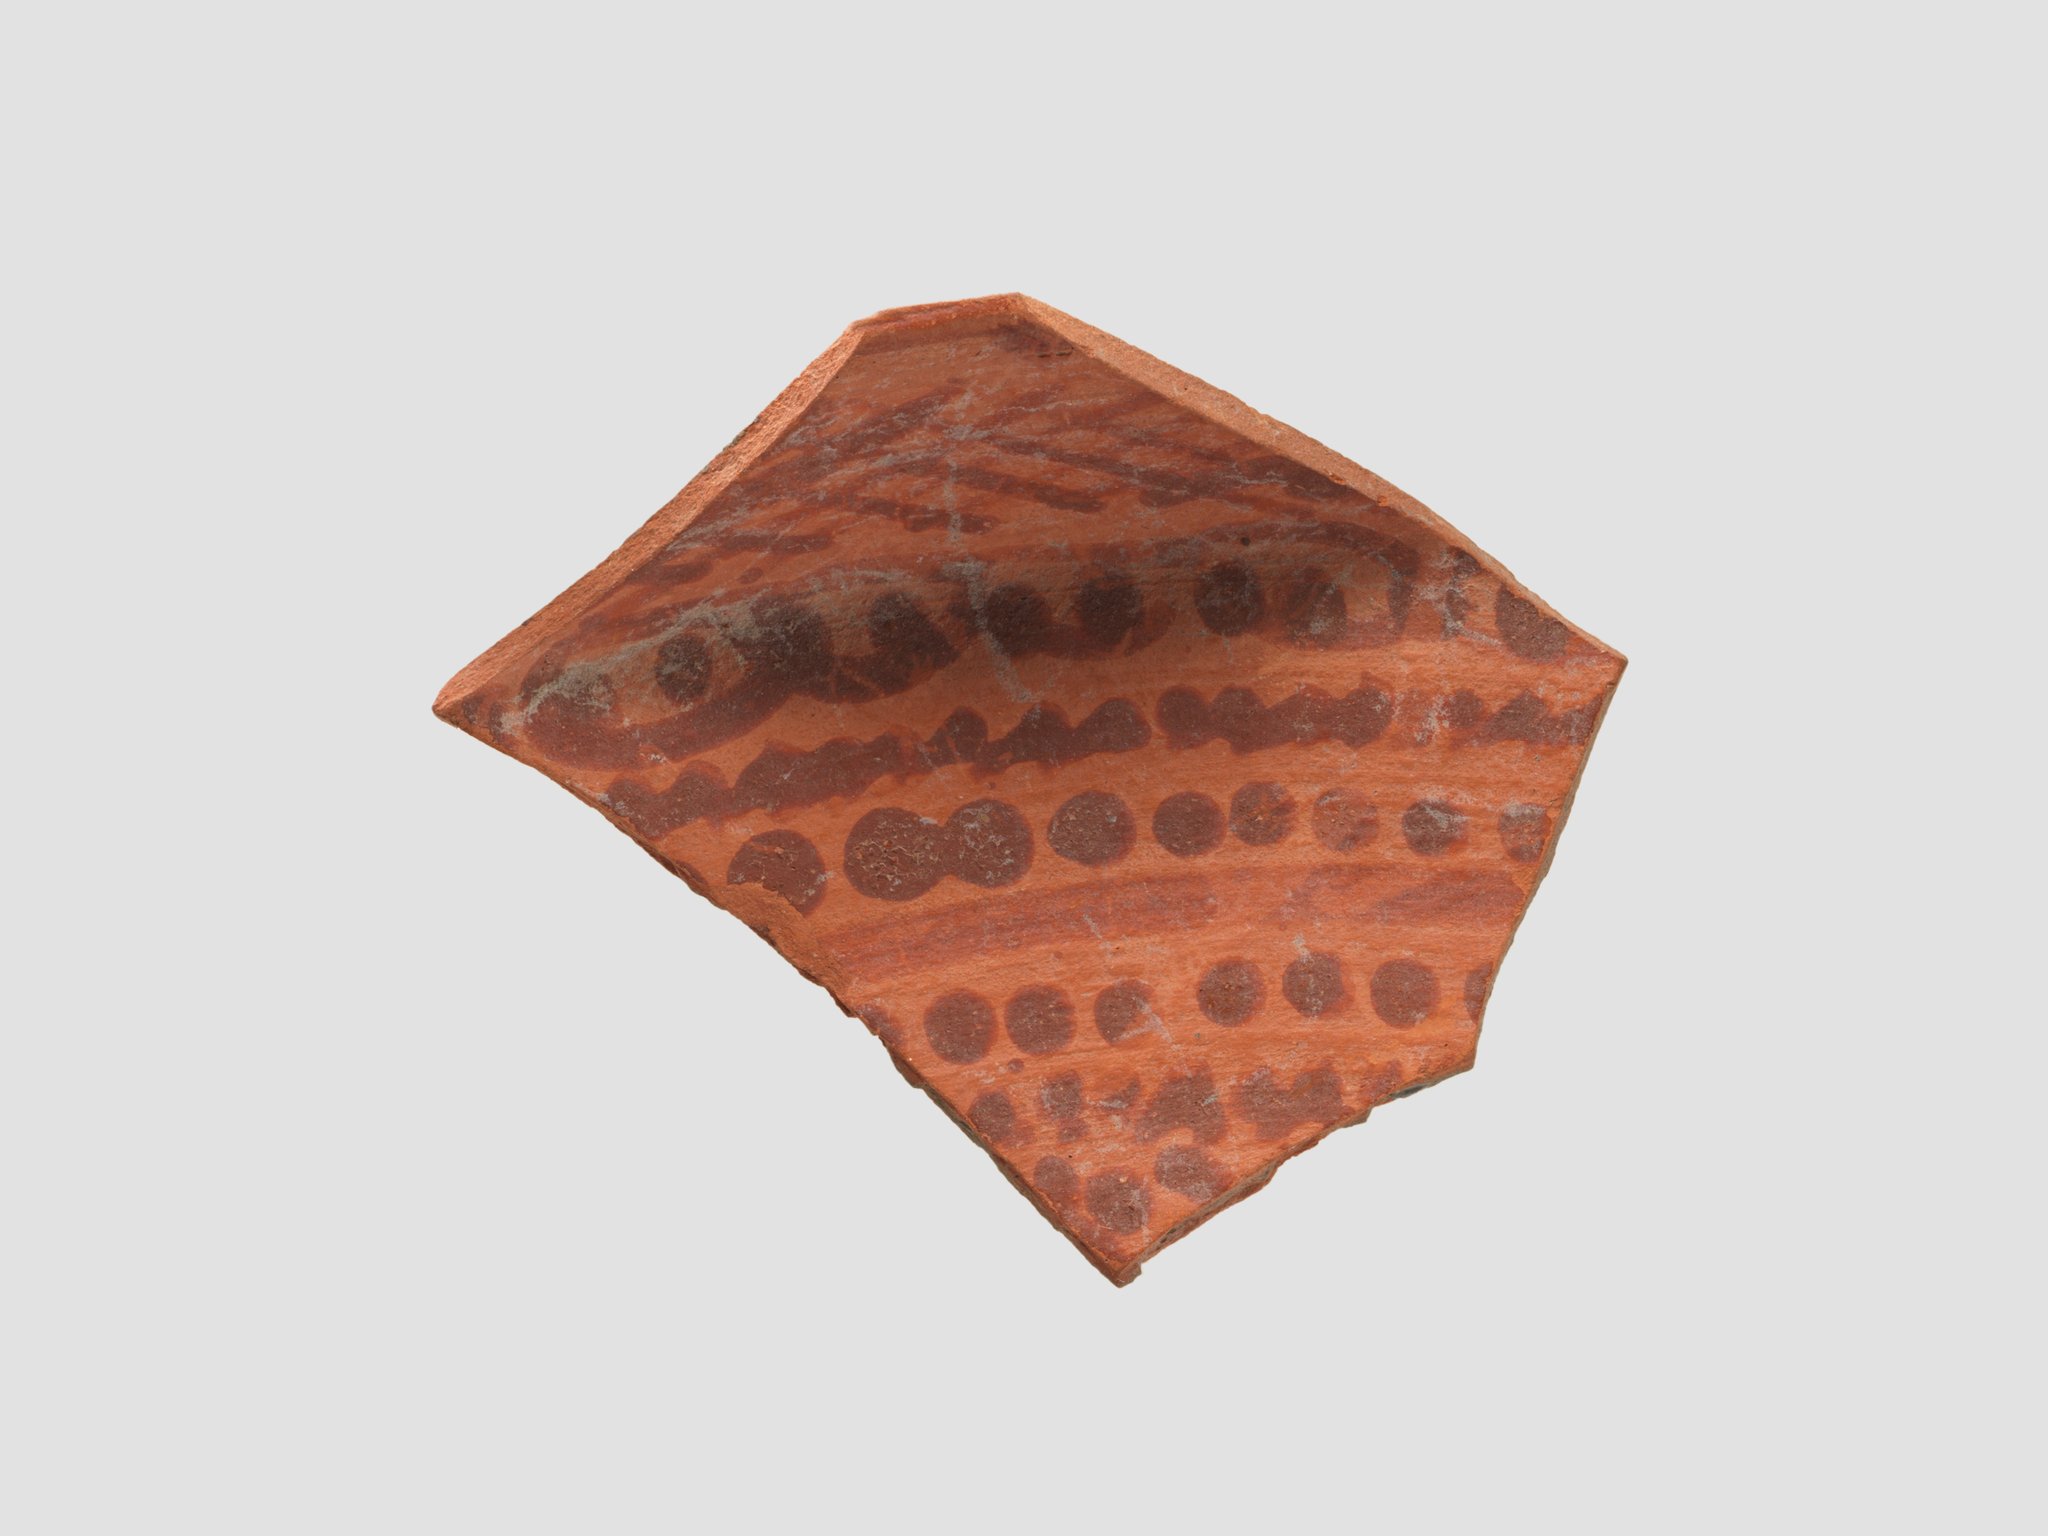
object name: sherd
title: Fragment of painted ware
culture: nabataean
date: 1-100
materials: ceramic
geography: levant